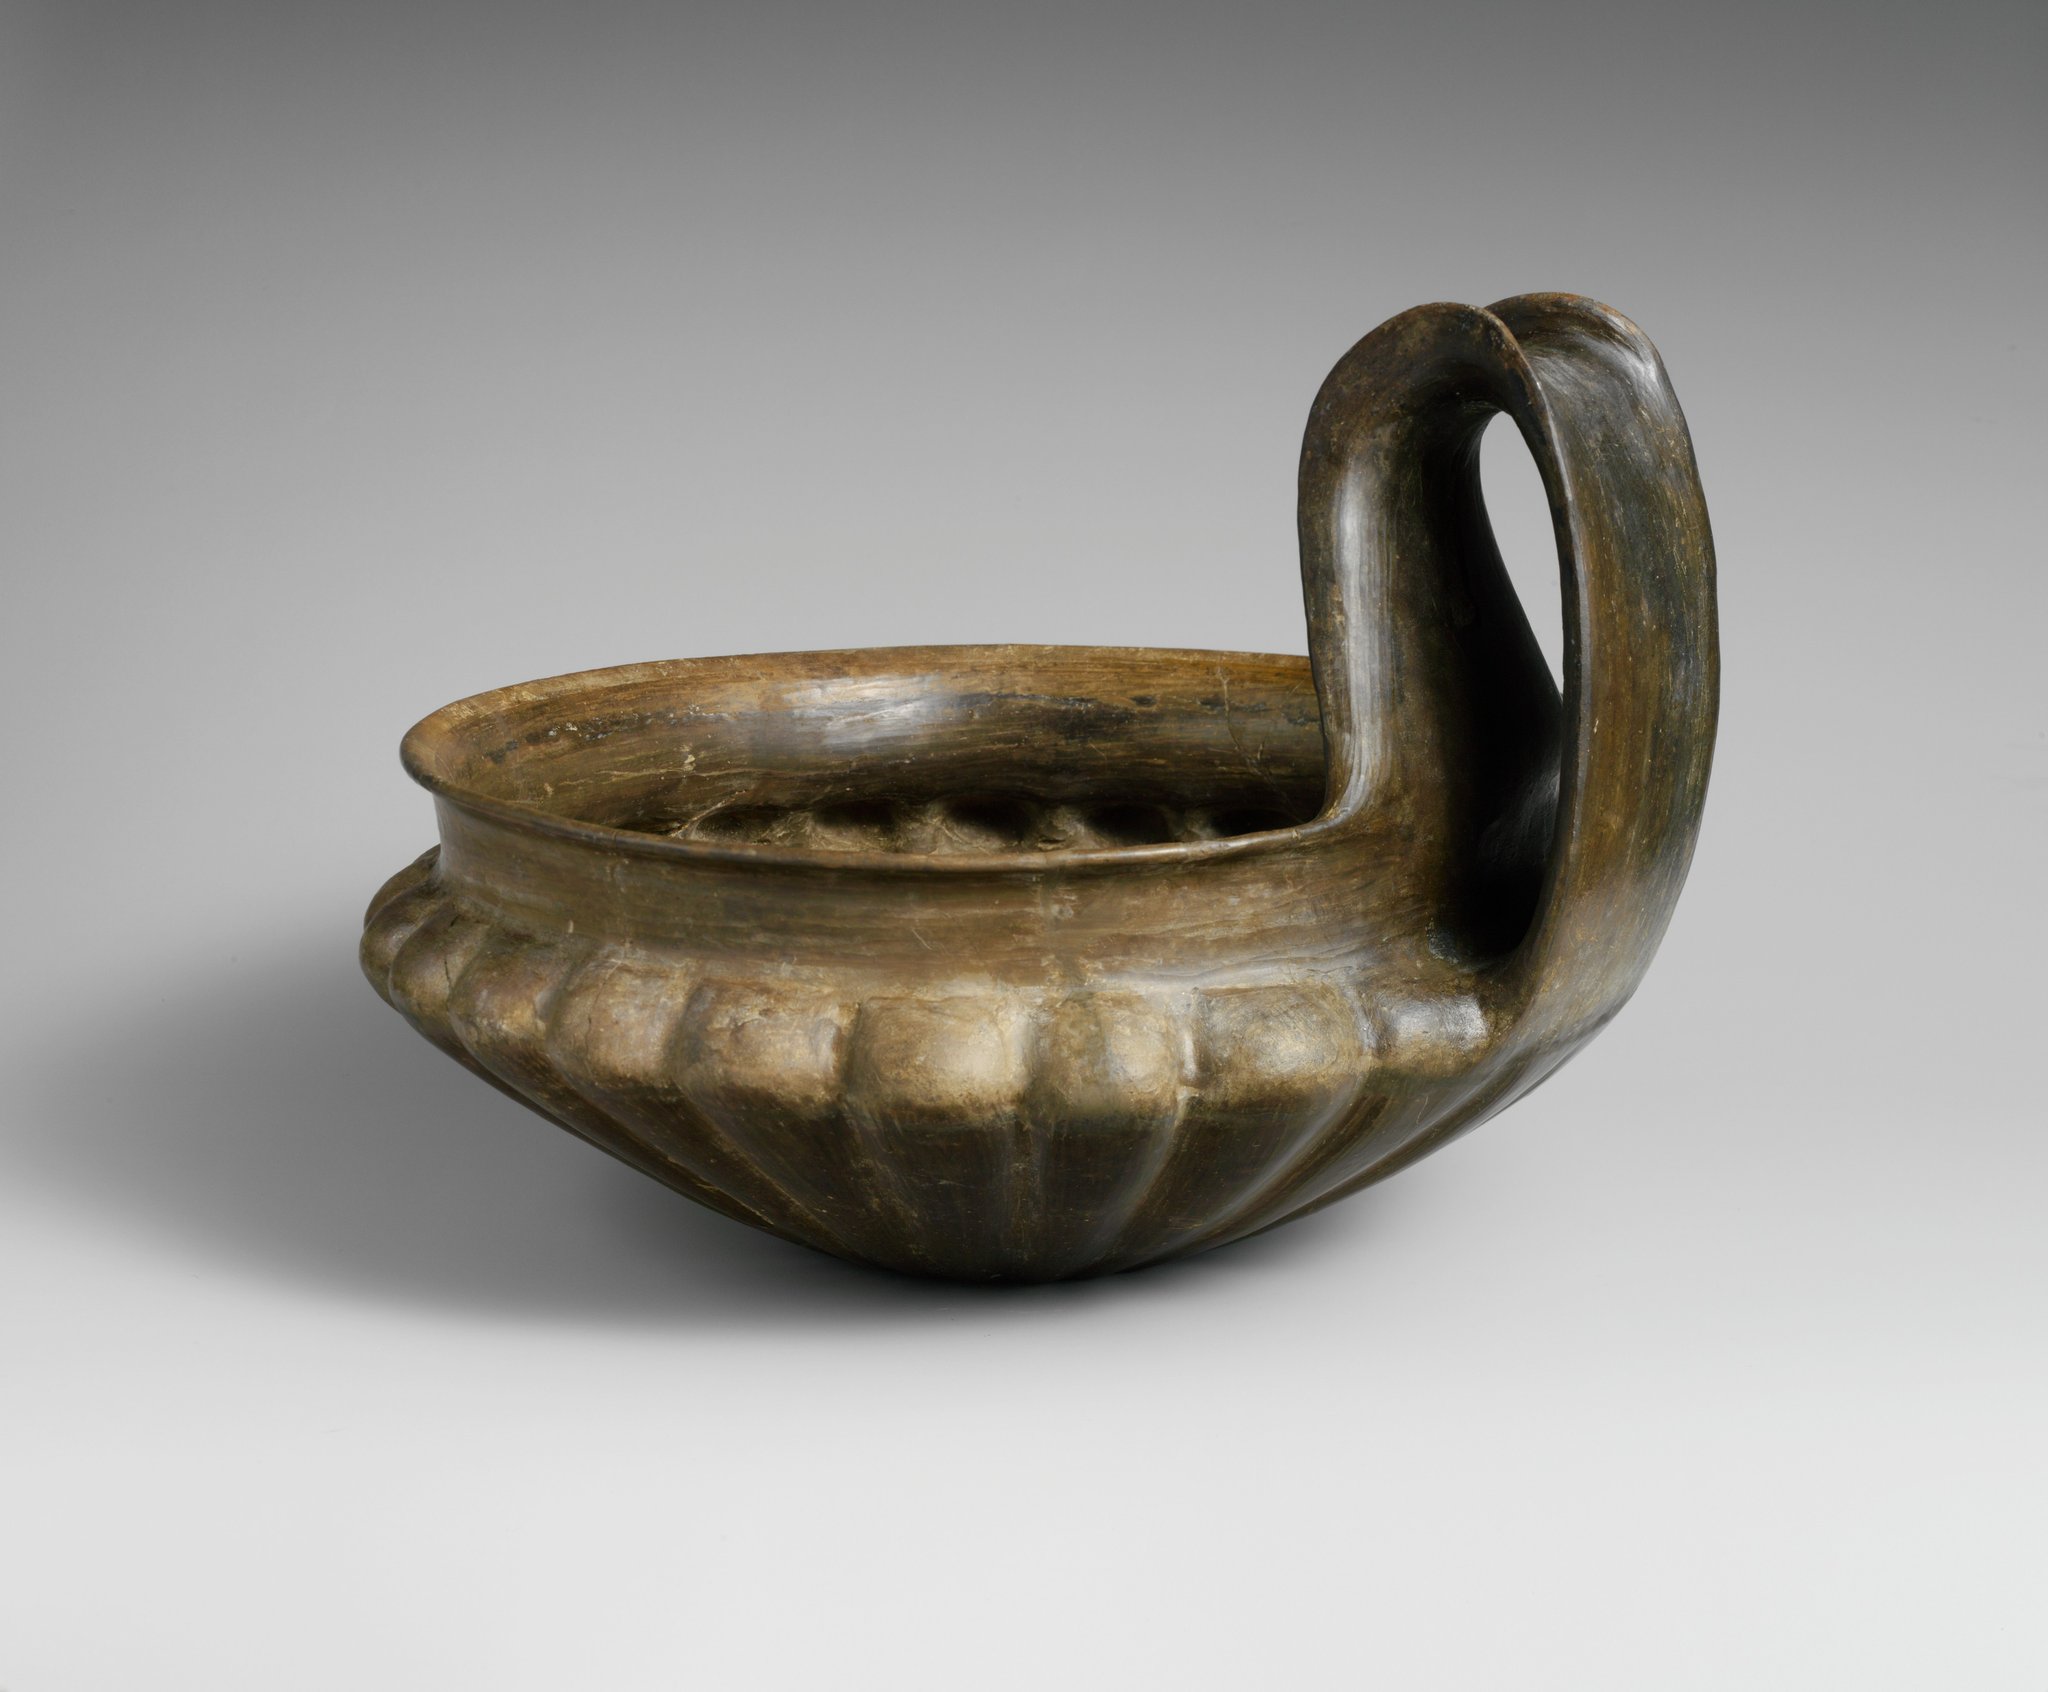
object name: kyathos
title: Terracotta kyathos (single-handled cup)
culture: villanovan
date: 700-601 BCE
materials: terracotta